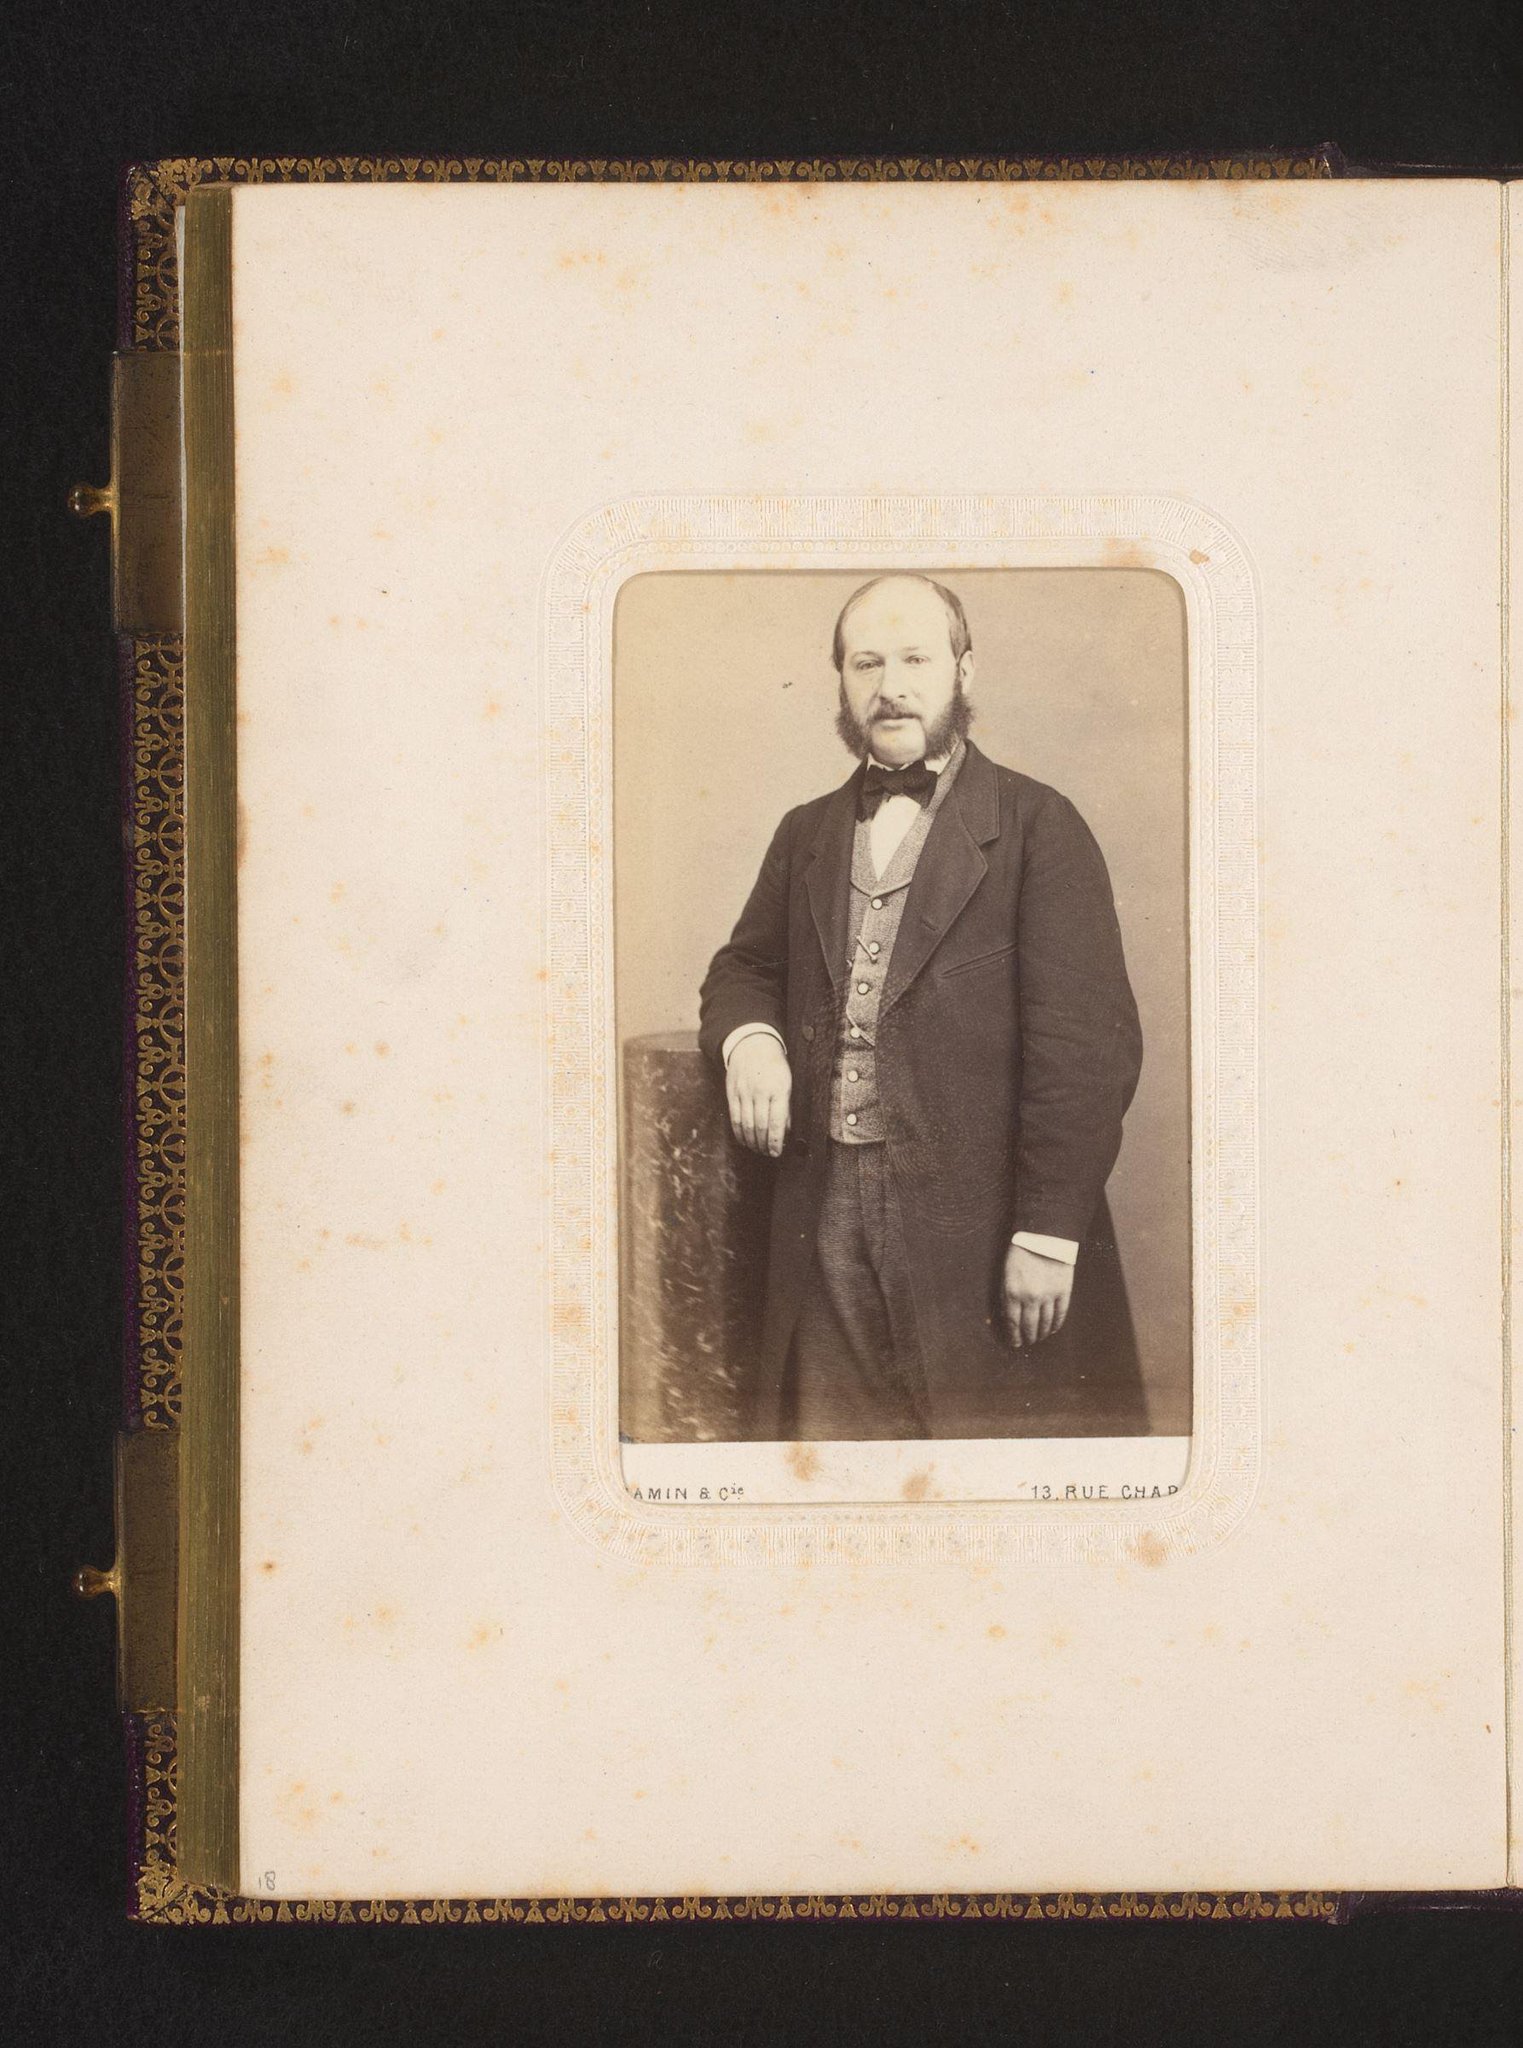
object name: album leaf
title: Portret van een staande man met snor en bakkebaarden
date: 1860-1900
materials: cardboard, photographic support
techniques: albumen print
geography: paris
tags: sideburns, moustache, historical persons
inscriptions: inscription: ‘PHOTOGRAPHIE/ JAMIN & Cie/ (Btes S.D.G.D.)/ 13, Rue Chapon, 13./ HÔTEL DE MONTBRISON/ Paris.’